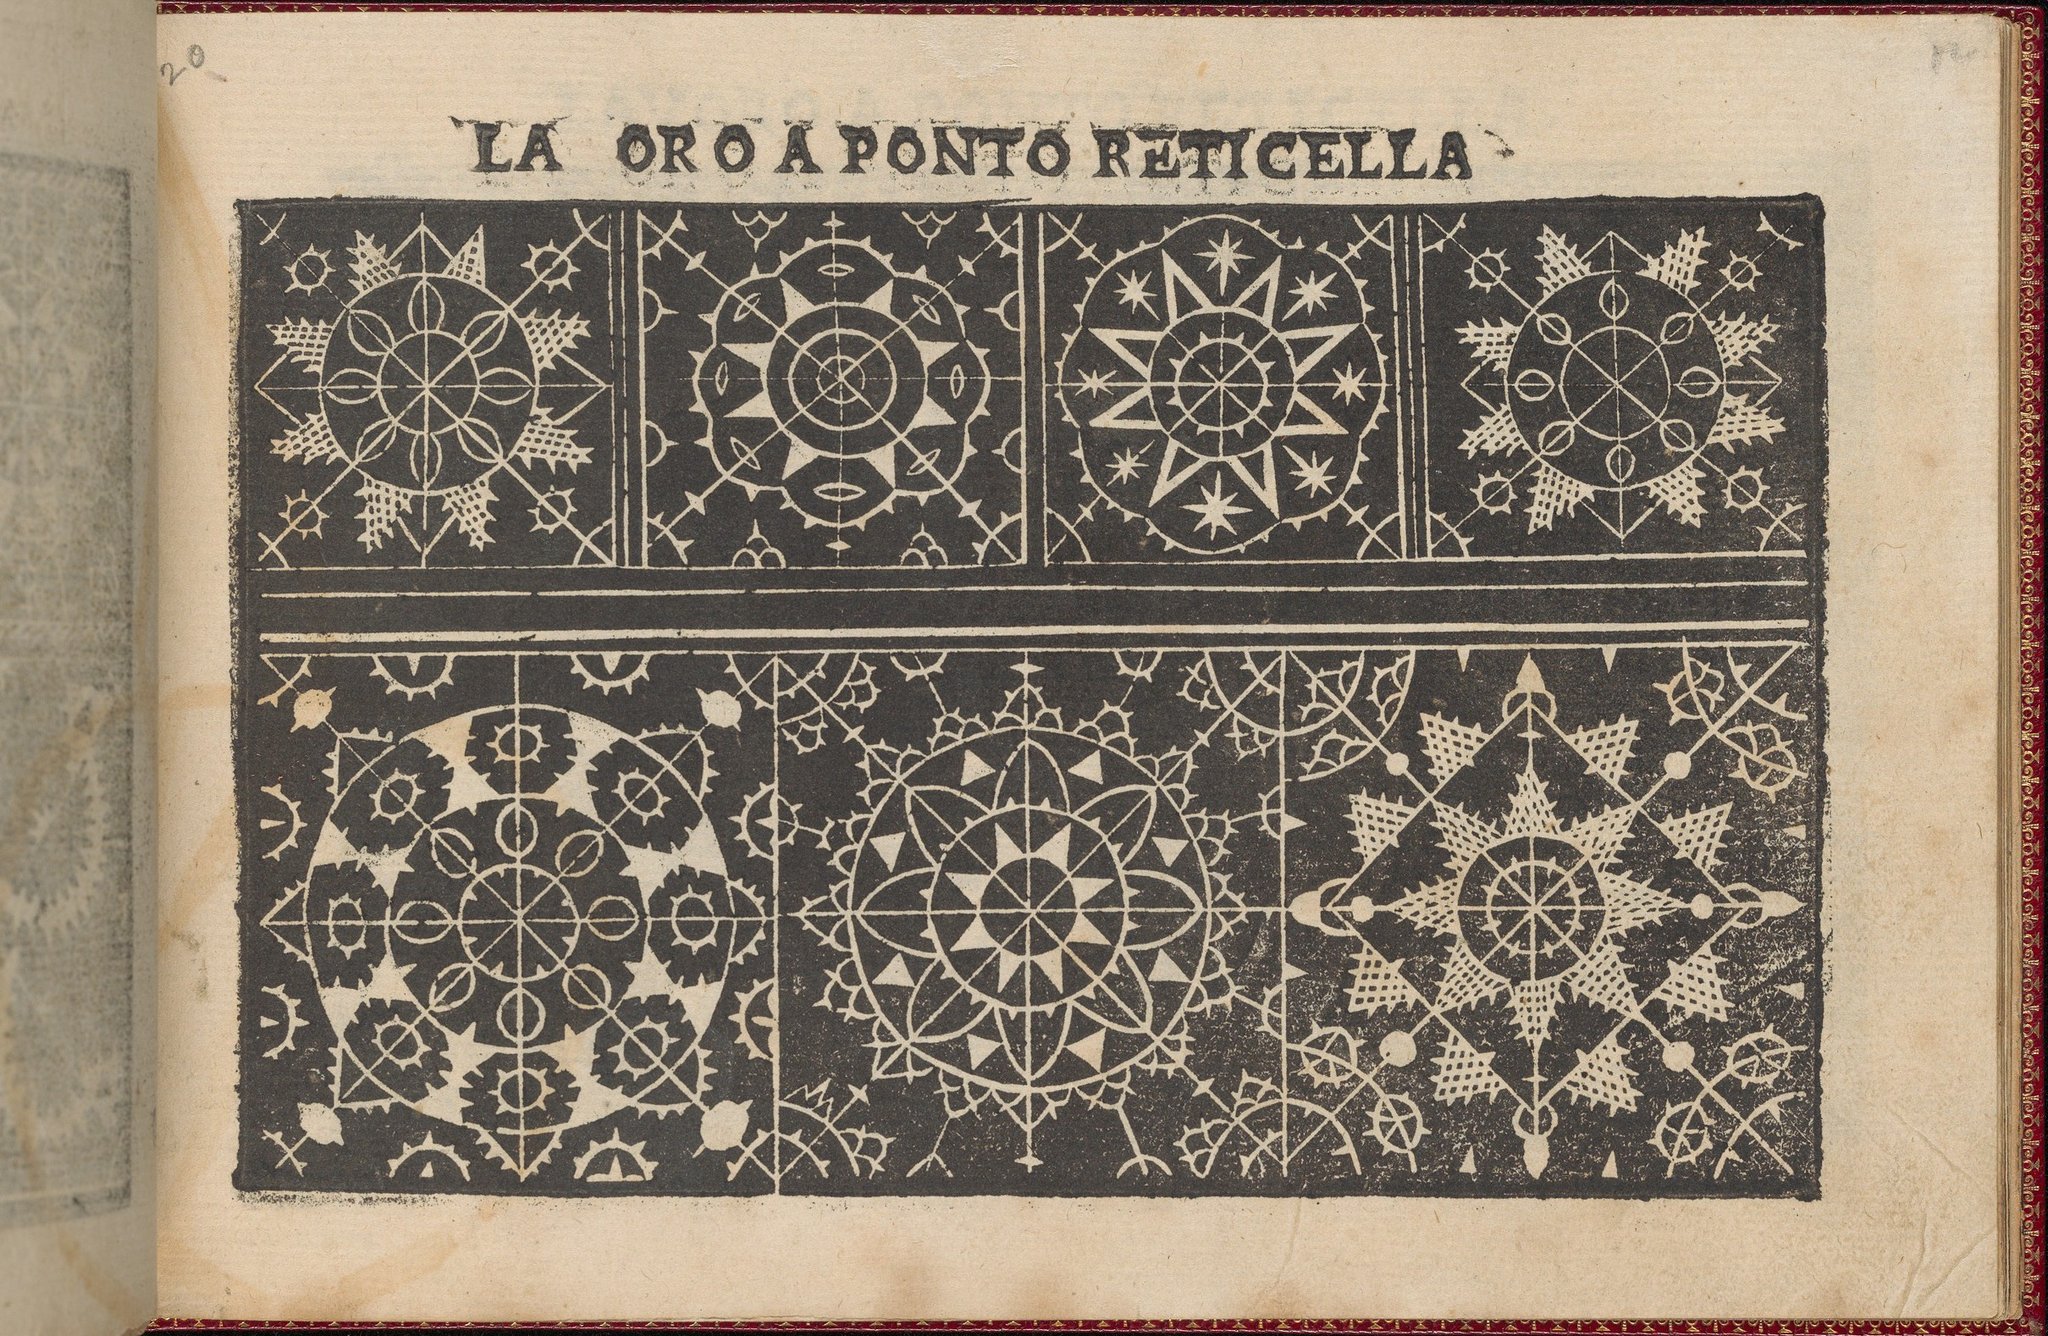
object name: book print ornament architecture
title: Pretiosa Gemma delle virtuose donne, page 14 (recto)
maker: isabella catanea parasole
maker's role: author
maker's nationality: italian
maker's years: 1565-1625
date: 1600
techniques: woodcut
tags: ornament